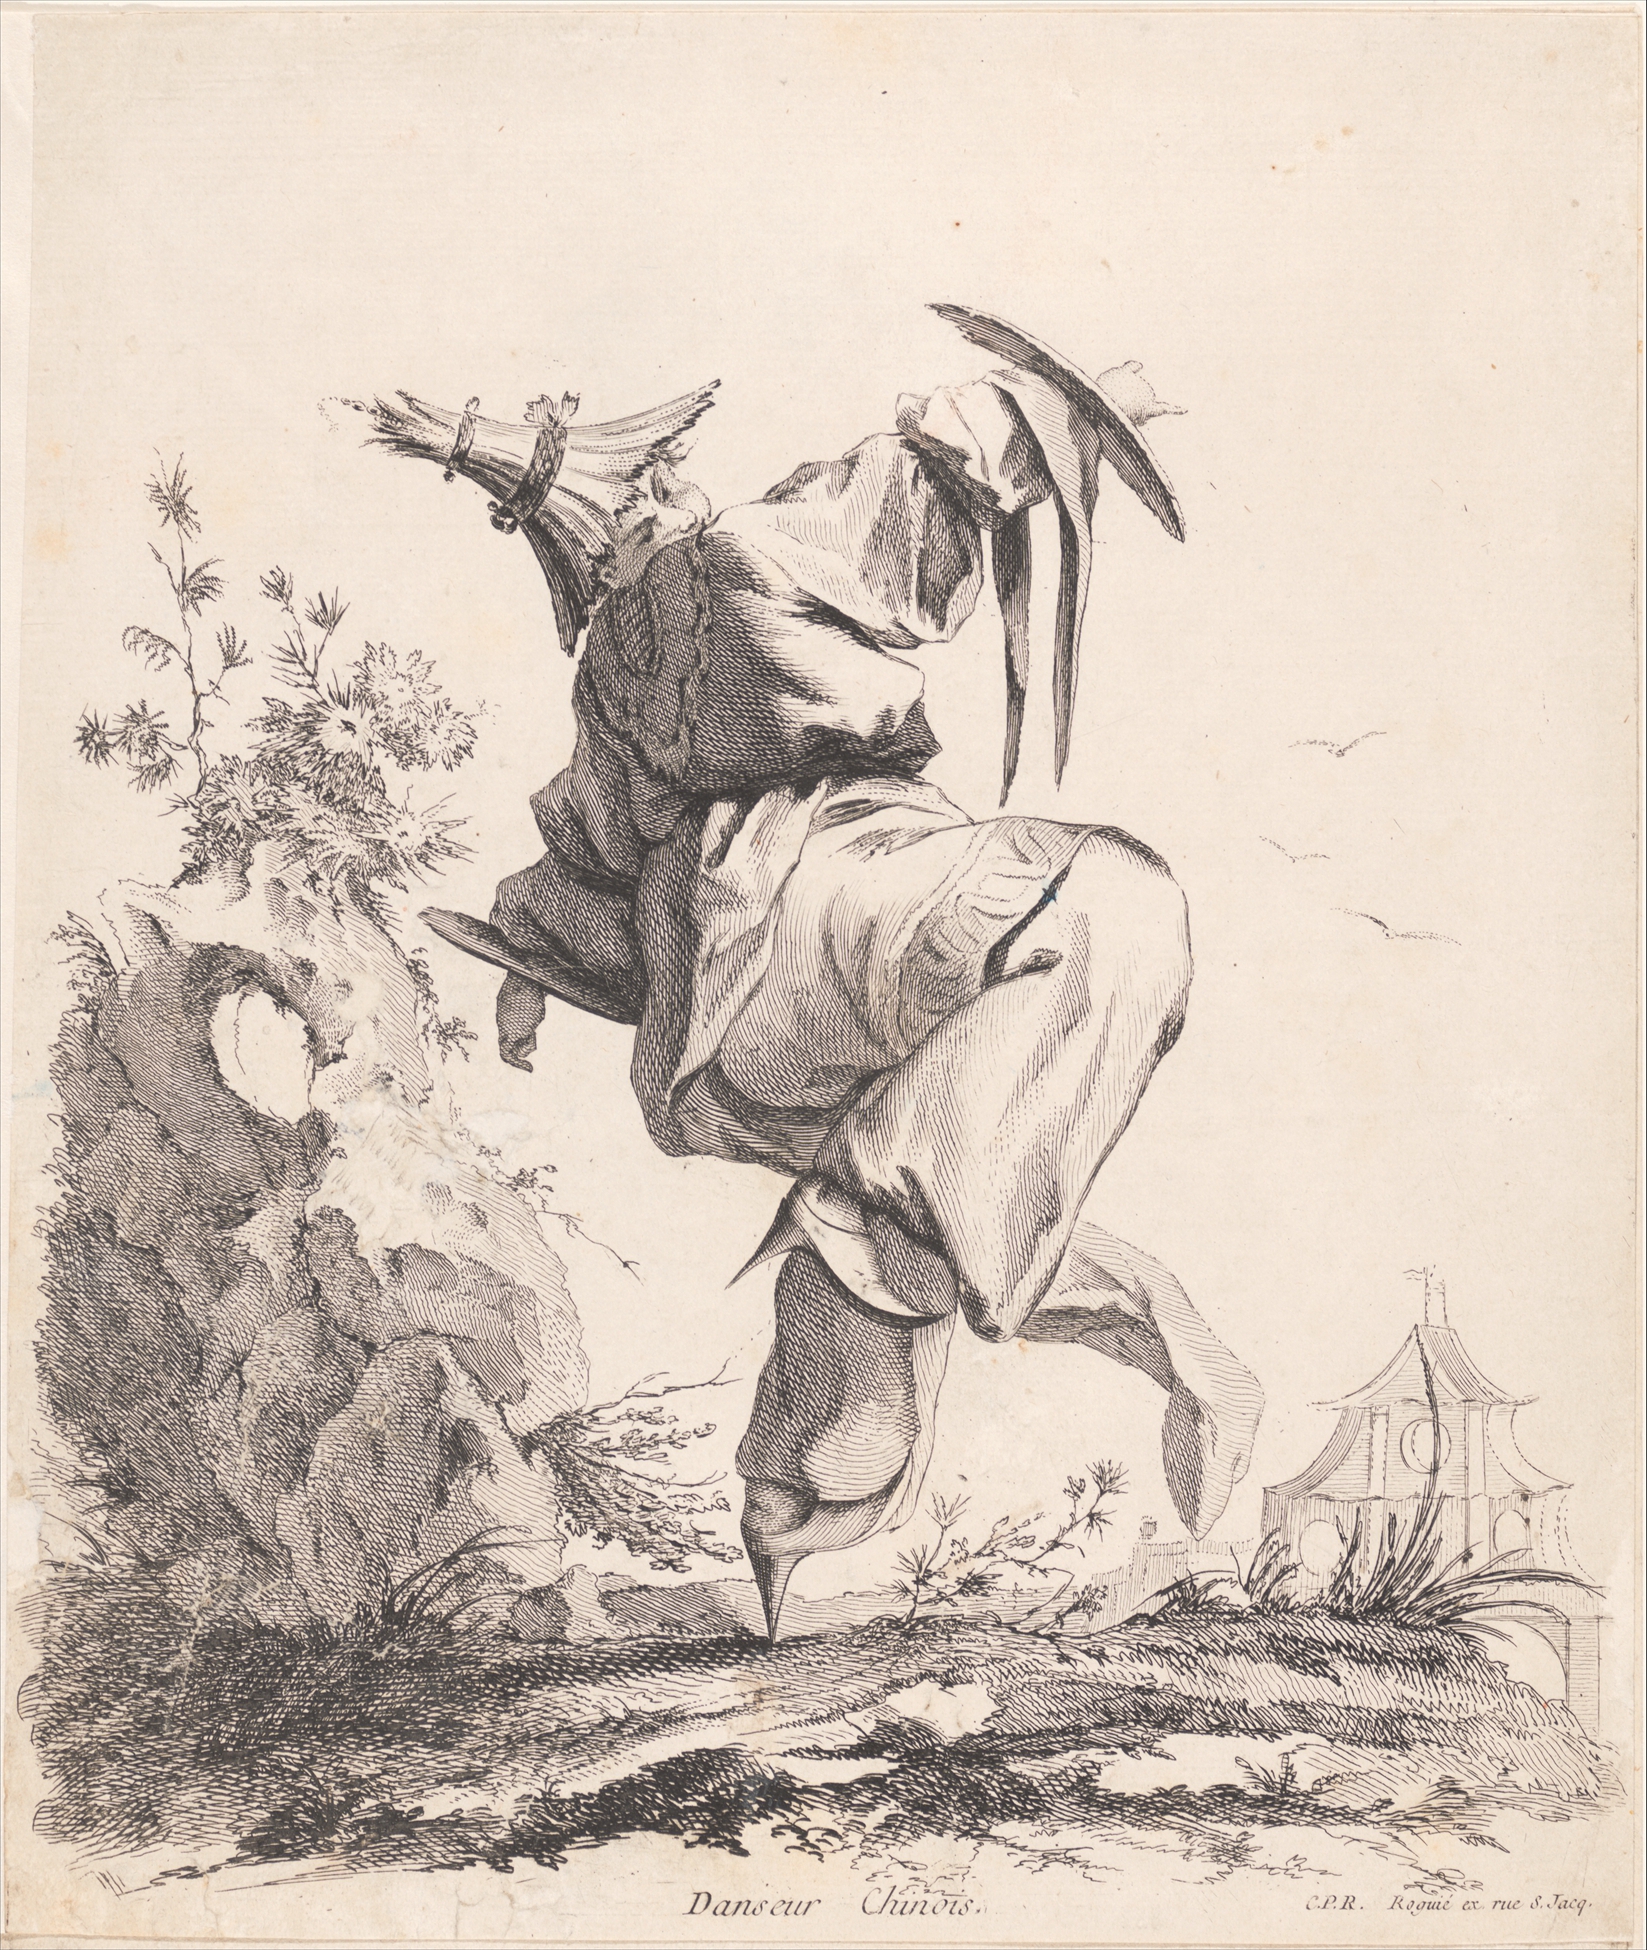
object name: print collection ornament architecture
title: Chinese Dancer, from Livre de Chinois (Book of Chinoiserie)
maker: françois boucher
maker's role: artist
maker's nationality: french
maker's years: 1703-1770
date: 1720-1770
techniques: engraving, etching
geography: france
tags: human figures,chinoiserie,dancing,dancers